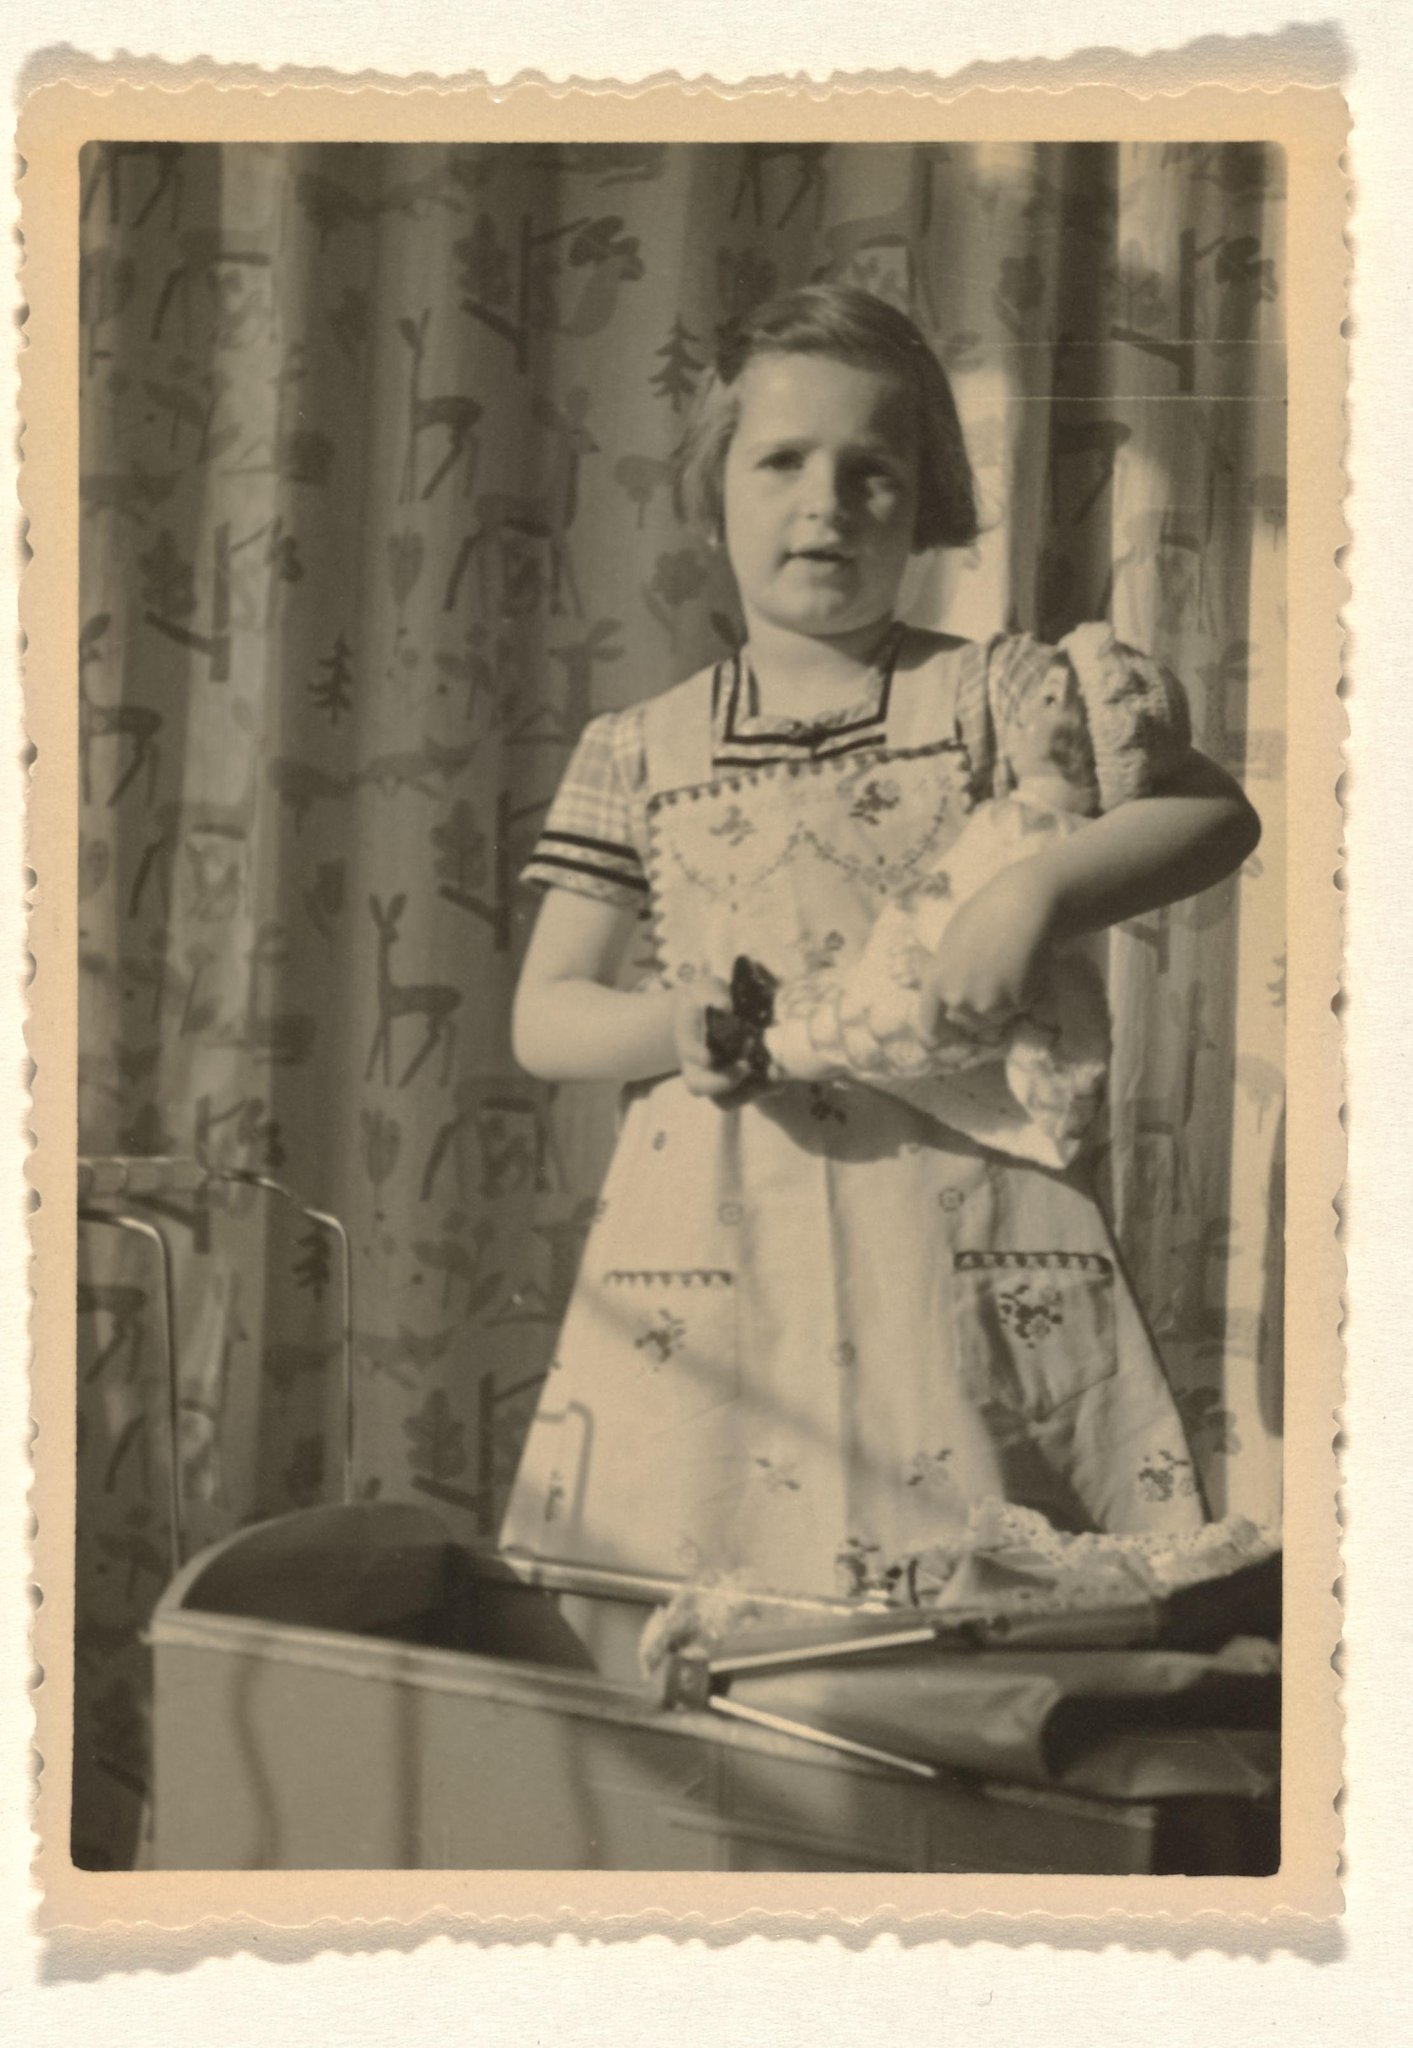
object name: photograph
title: Isabel Wachenheimer voor een kinderwagen en met een pop in haar armen, april-mei 1935, Stuttgart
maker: Anonymous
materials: photographic support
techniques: gelatin silver print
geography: stuttgart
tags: isabel wachenheimer-elon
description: Isabel Wachenheimer voor een kinderwagen en met een pop in haar armen.